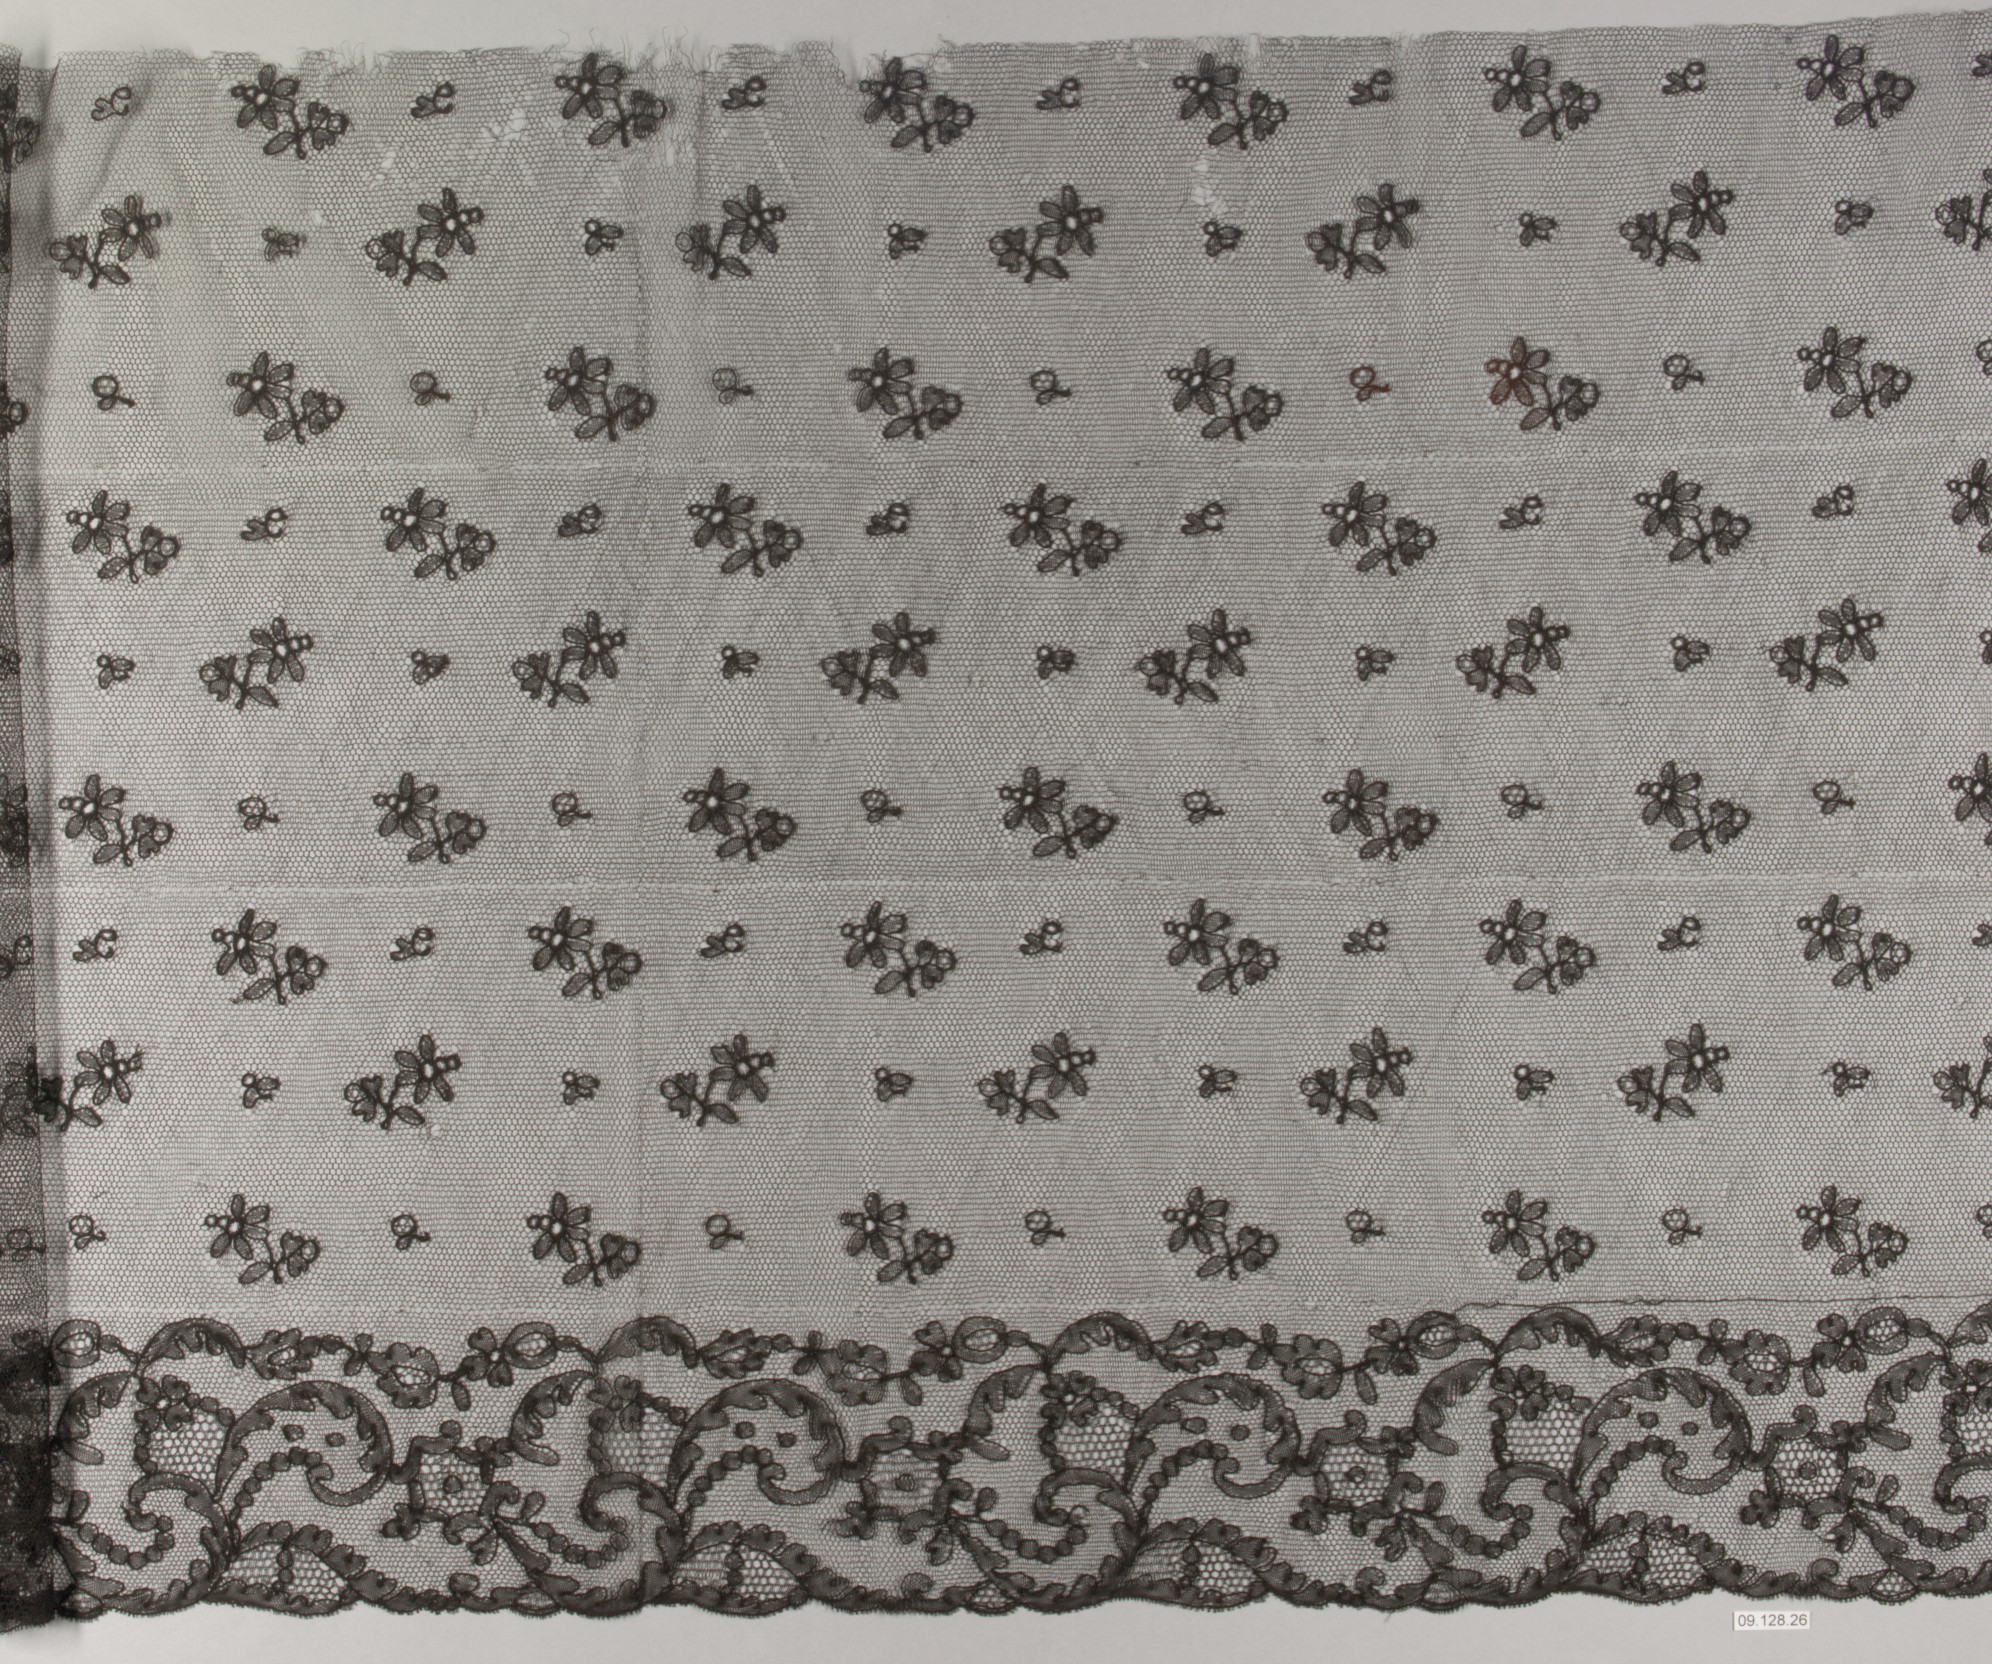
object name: veil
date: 1801-1900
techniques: lace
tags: flowers